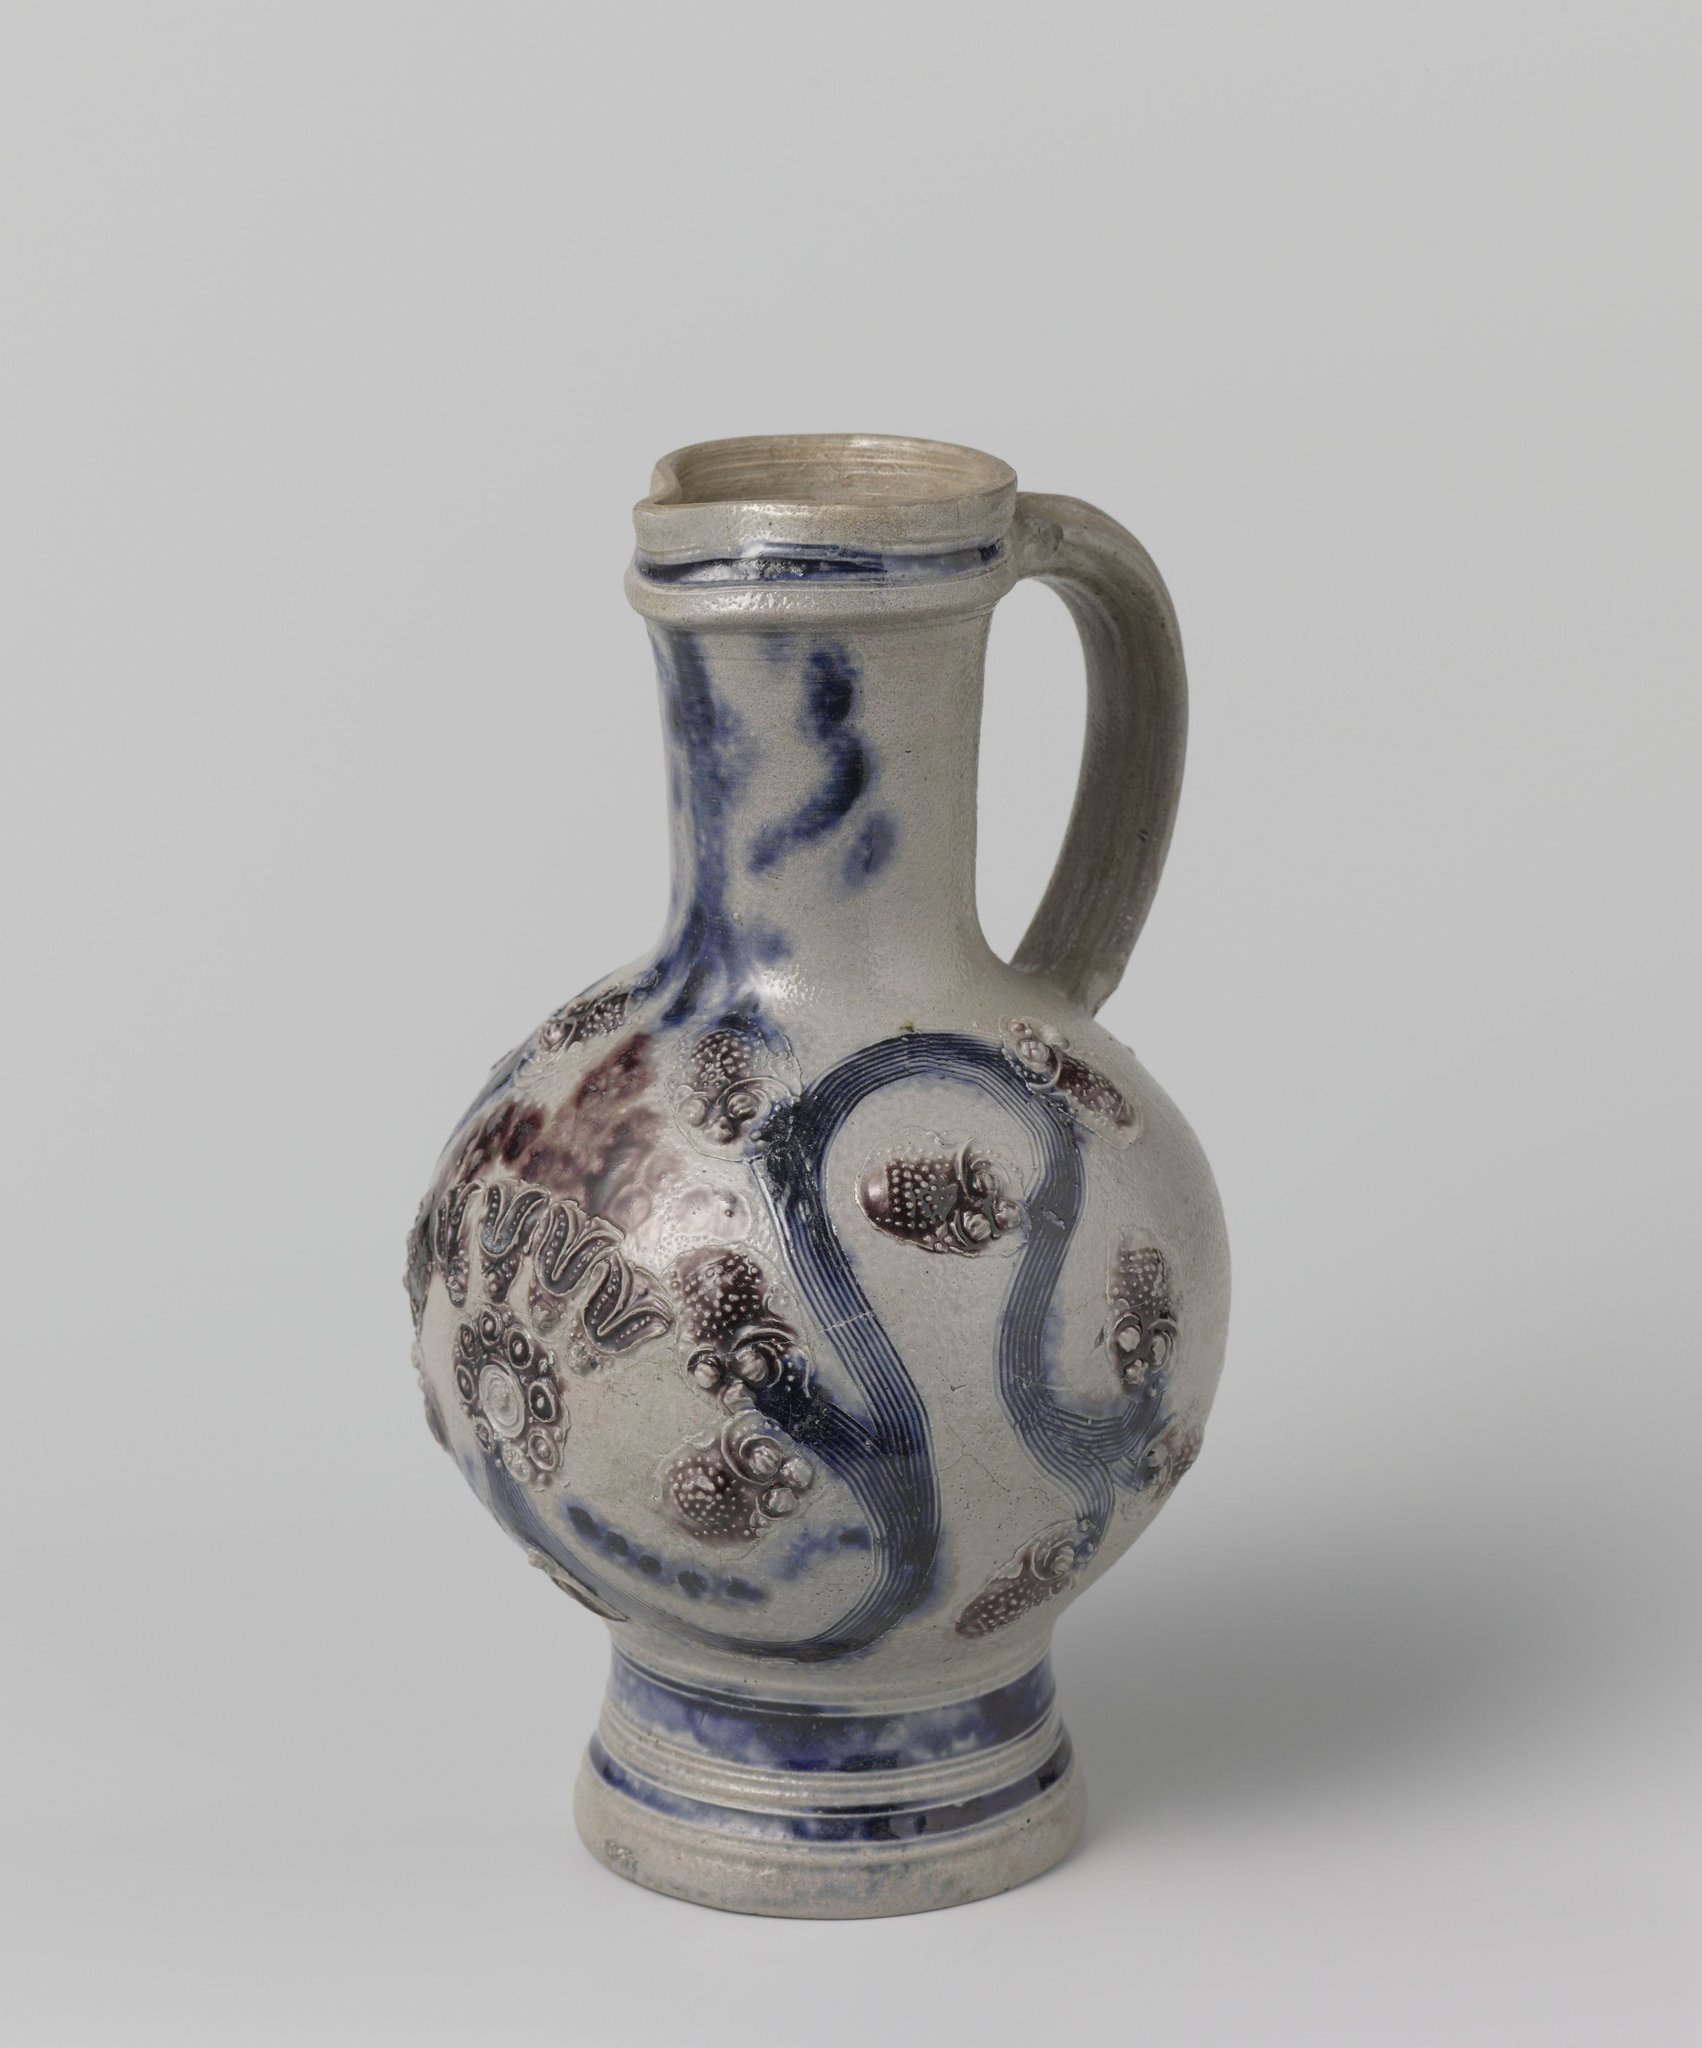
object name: ewer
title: Jug with floral scrolls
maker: Anonymous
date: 1680-1740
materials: cobalt, glaze, mineral, stoneware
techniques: firing, forming, relief, turning, vitrification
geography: westerwald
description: Kan van steengoed op hoge voet met een bolvormig lichaam en lange nek met een geknepen tuit. Het C-vormige oor is bevestigd aan de nek en de schouder. Profielen op de voet en de nek. Gedeeltelijk bedekt met kobaltblauw en mangaanpaars. De kan is versierd met ingegrifte ranken en gedrukte, opgelegde bloemen in reliëf. Westerwald.